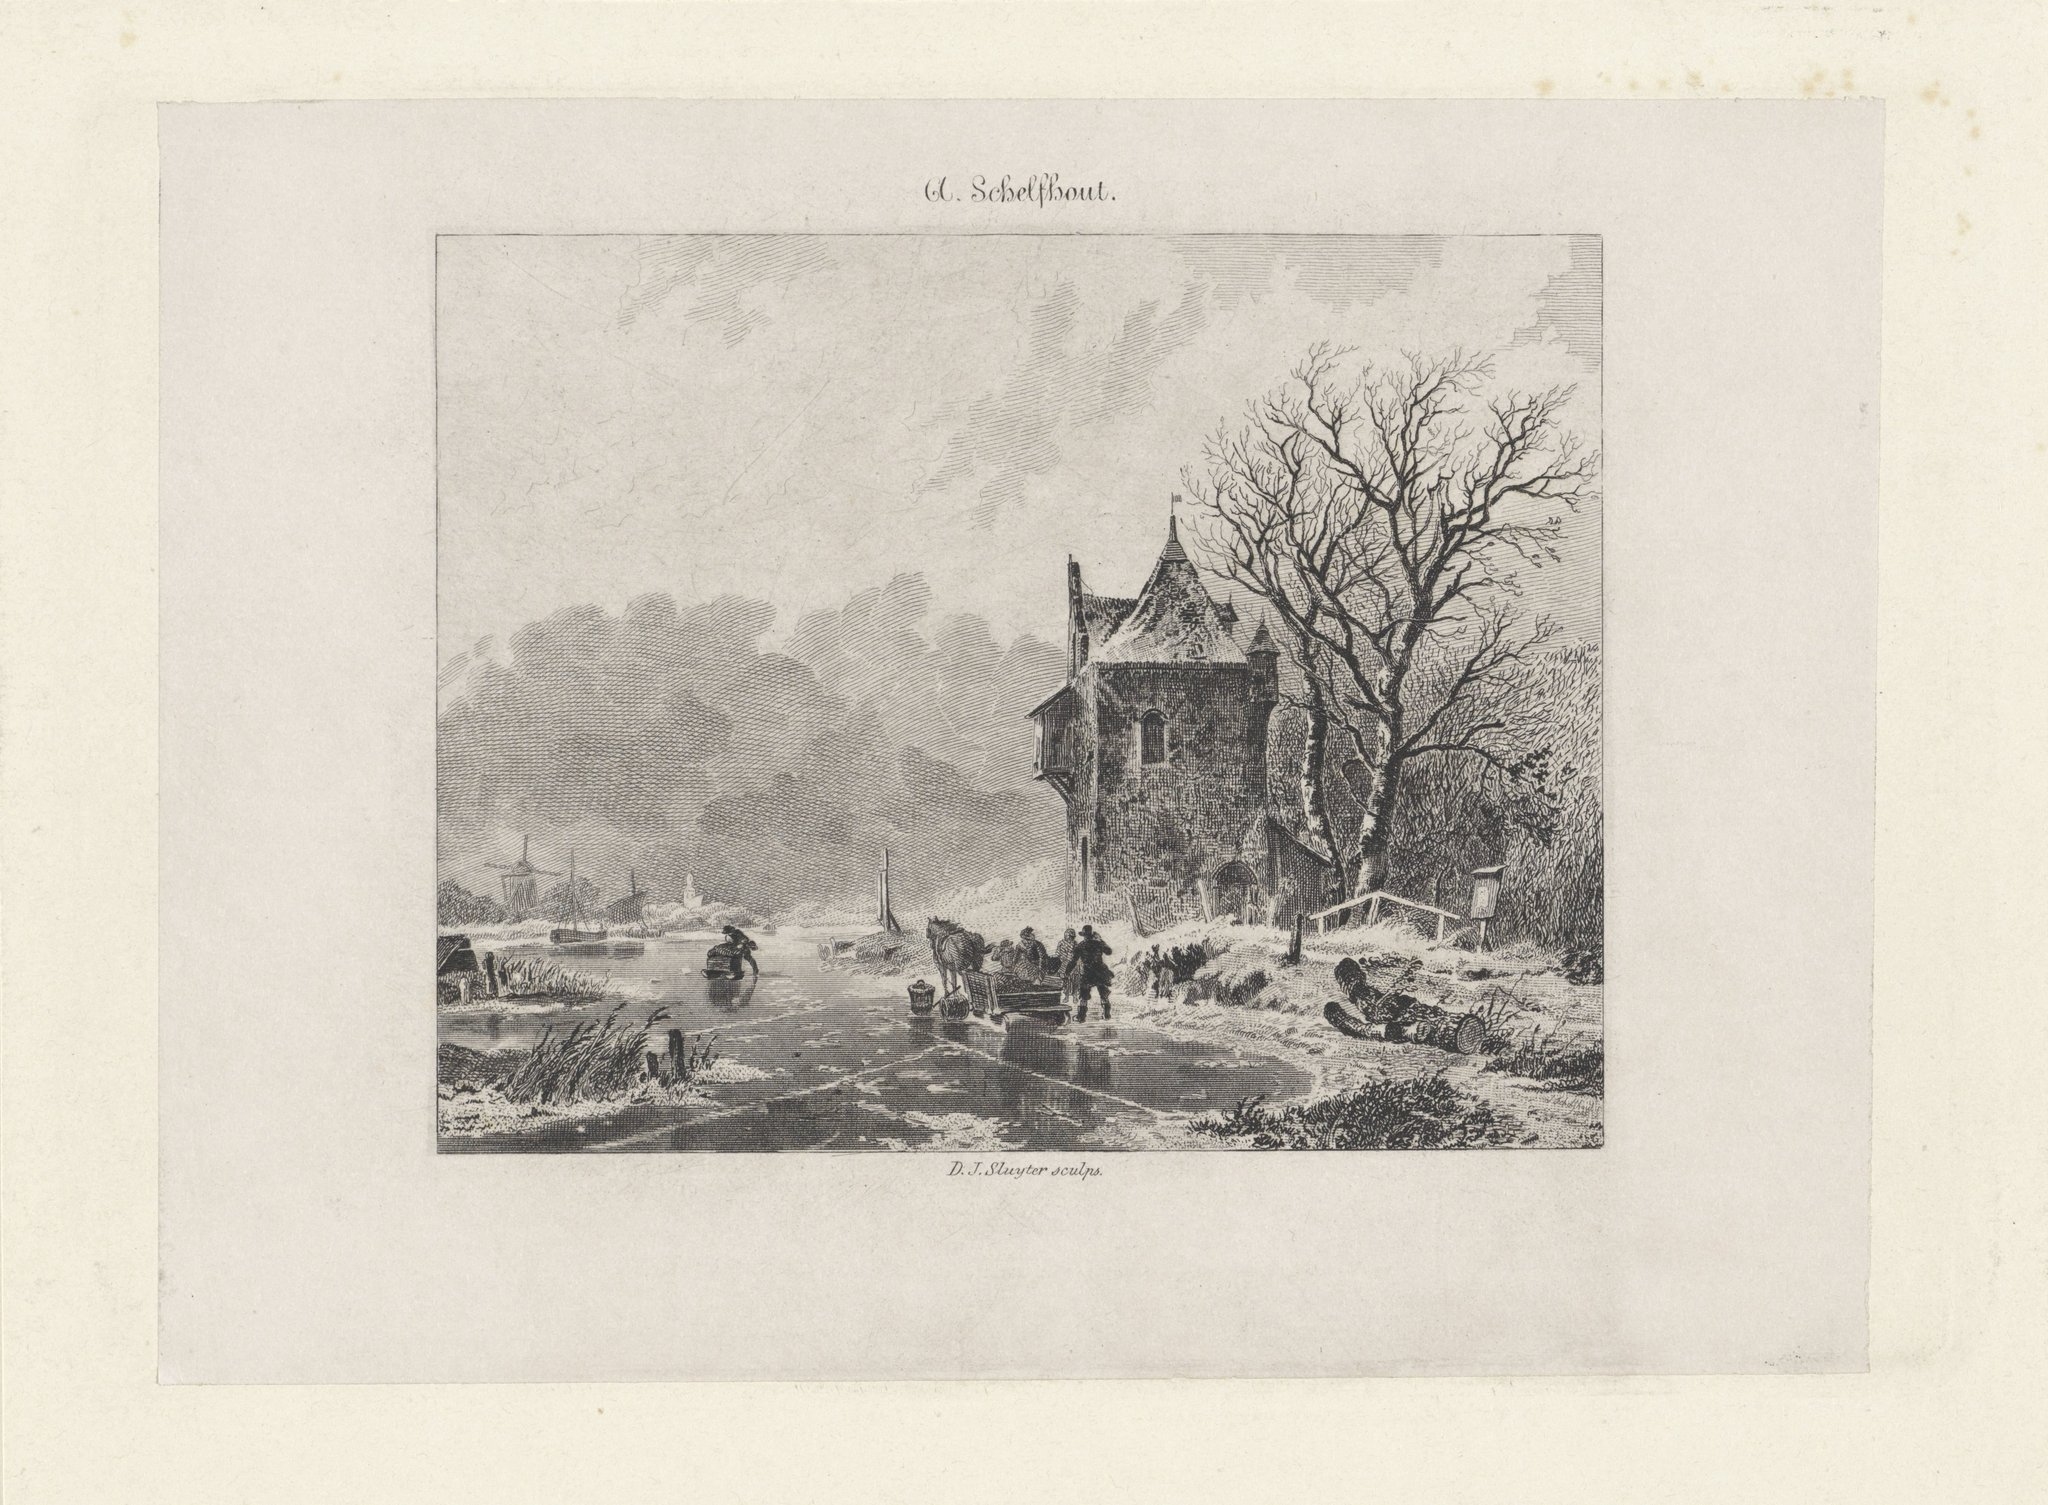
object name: print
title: Winterlandschap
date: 1821-1886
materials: paper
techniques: etching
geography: amsterdam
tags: winter ~ human activities (the four seasons of the year)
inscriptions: collector's mark: Lugt 2228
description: Op een bevroren vaart staat een paard met slee, waarin twee vrouwen en een kind instappen. Een man kijkt toe. Verderop schaatst een man met een slee die hij voortduwt. Aan de oever staat een hoog, smal huis met torentjes. Op de achtergrond een molen en een toren.